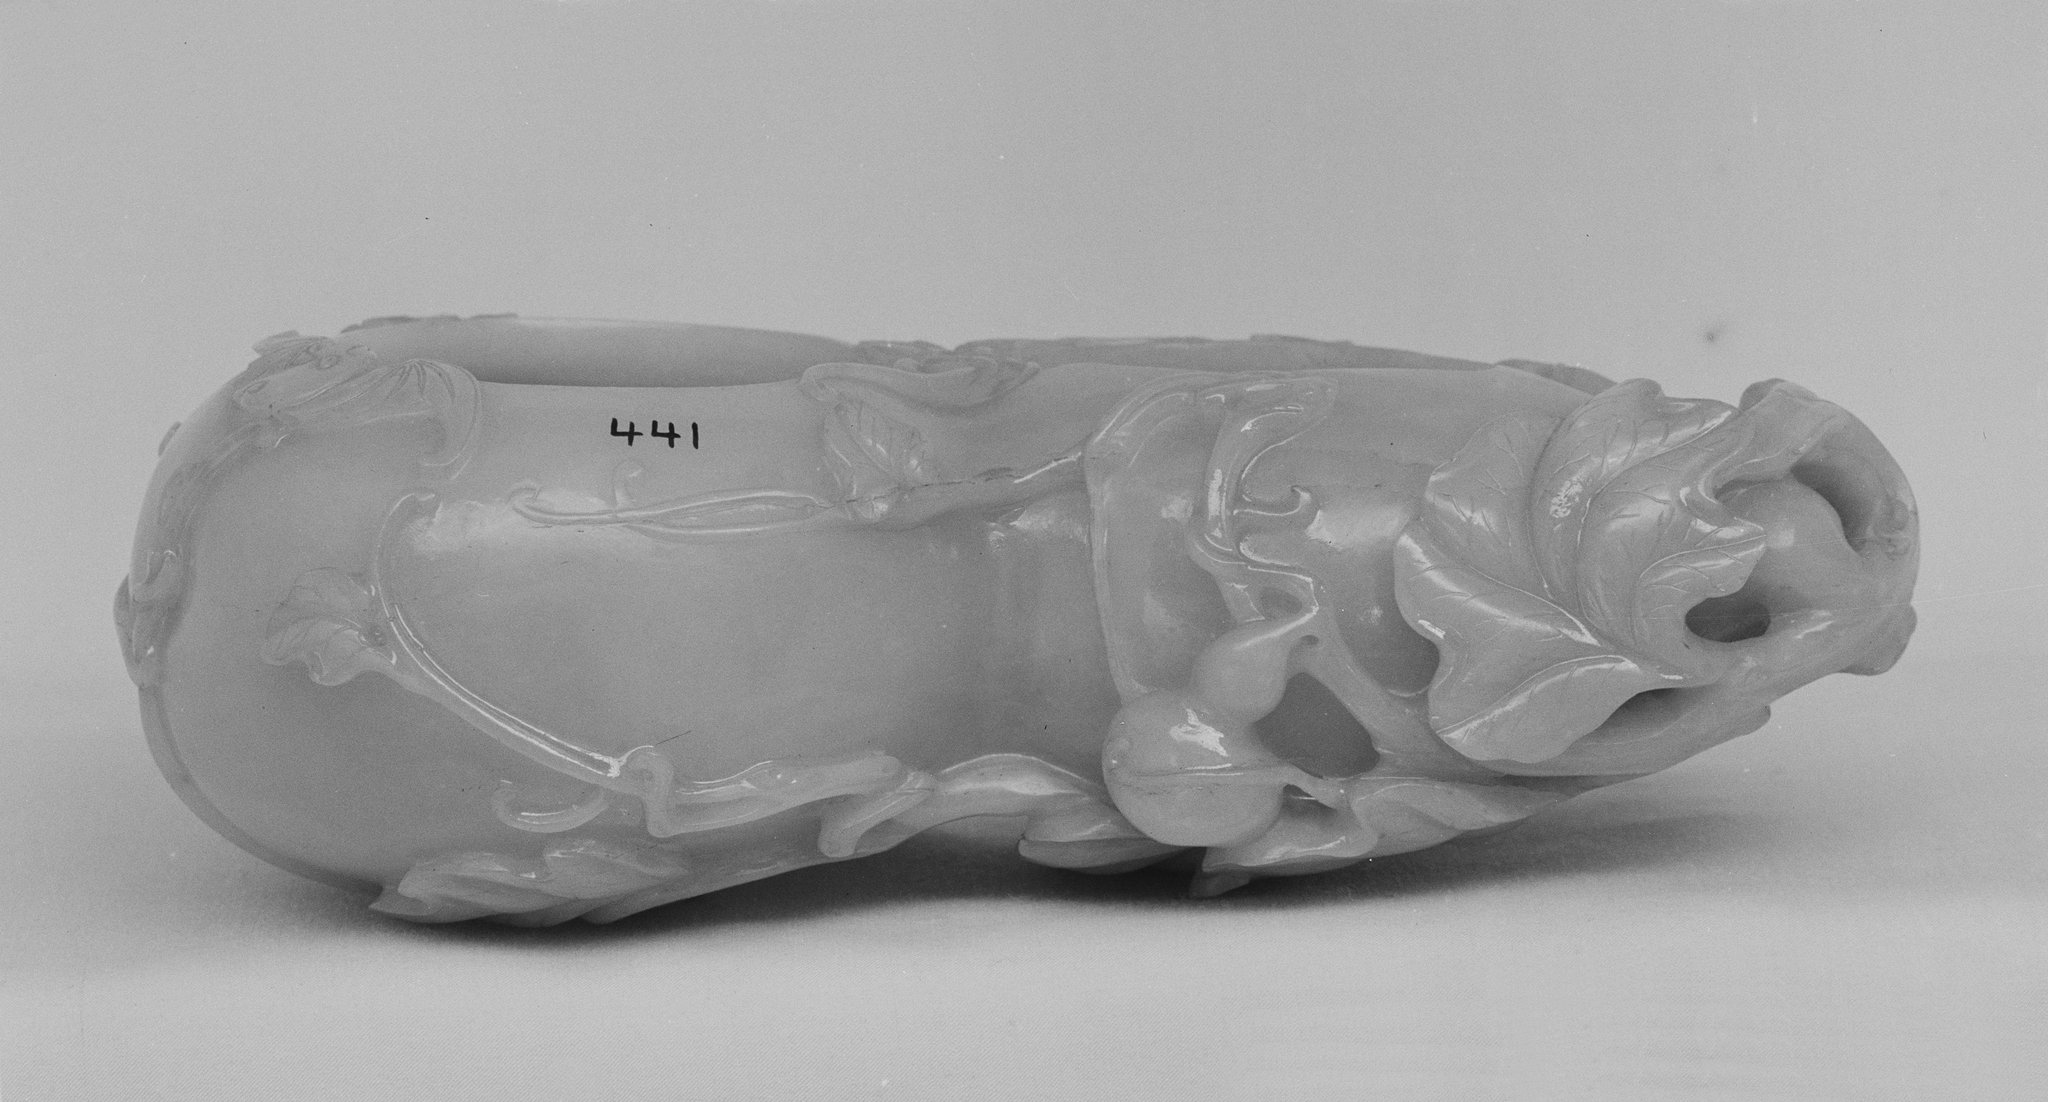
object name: vessel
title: Water vessel in the shape of a gourd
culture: chinese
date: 1701-1900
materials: jade